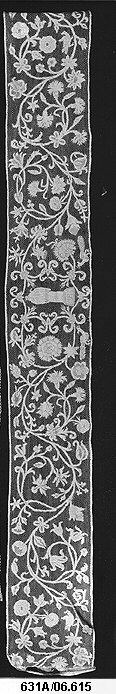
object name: border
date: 1701-1733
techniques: lace